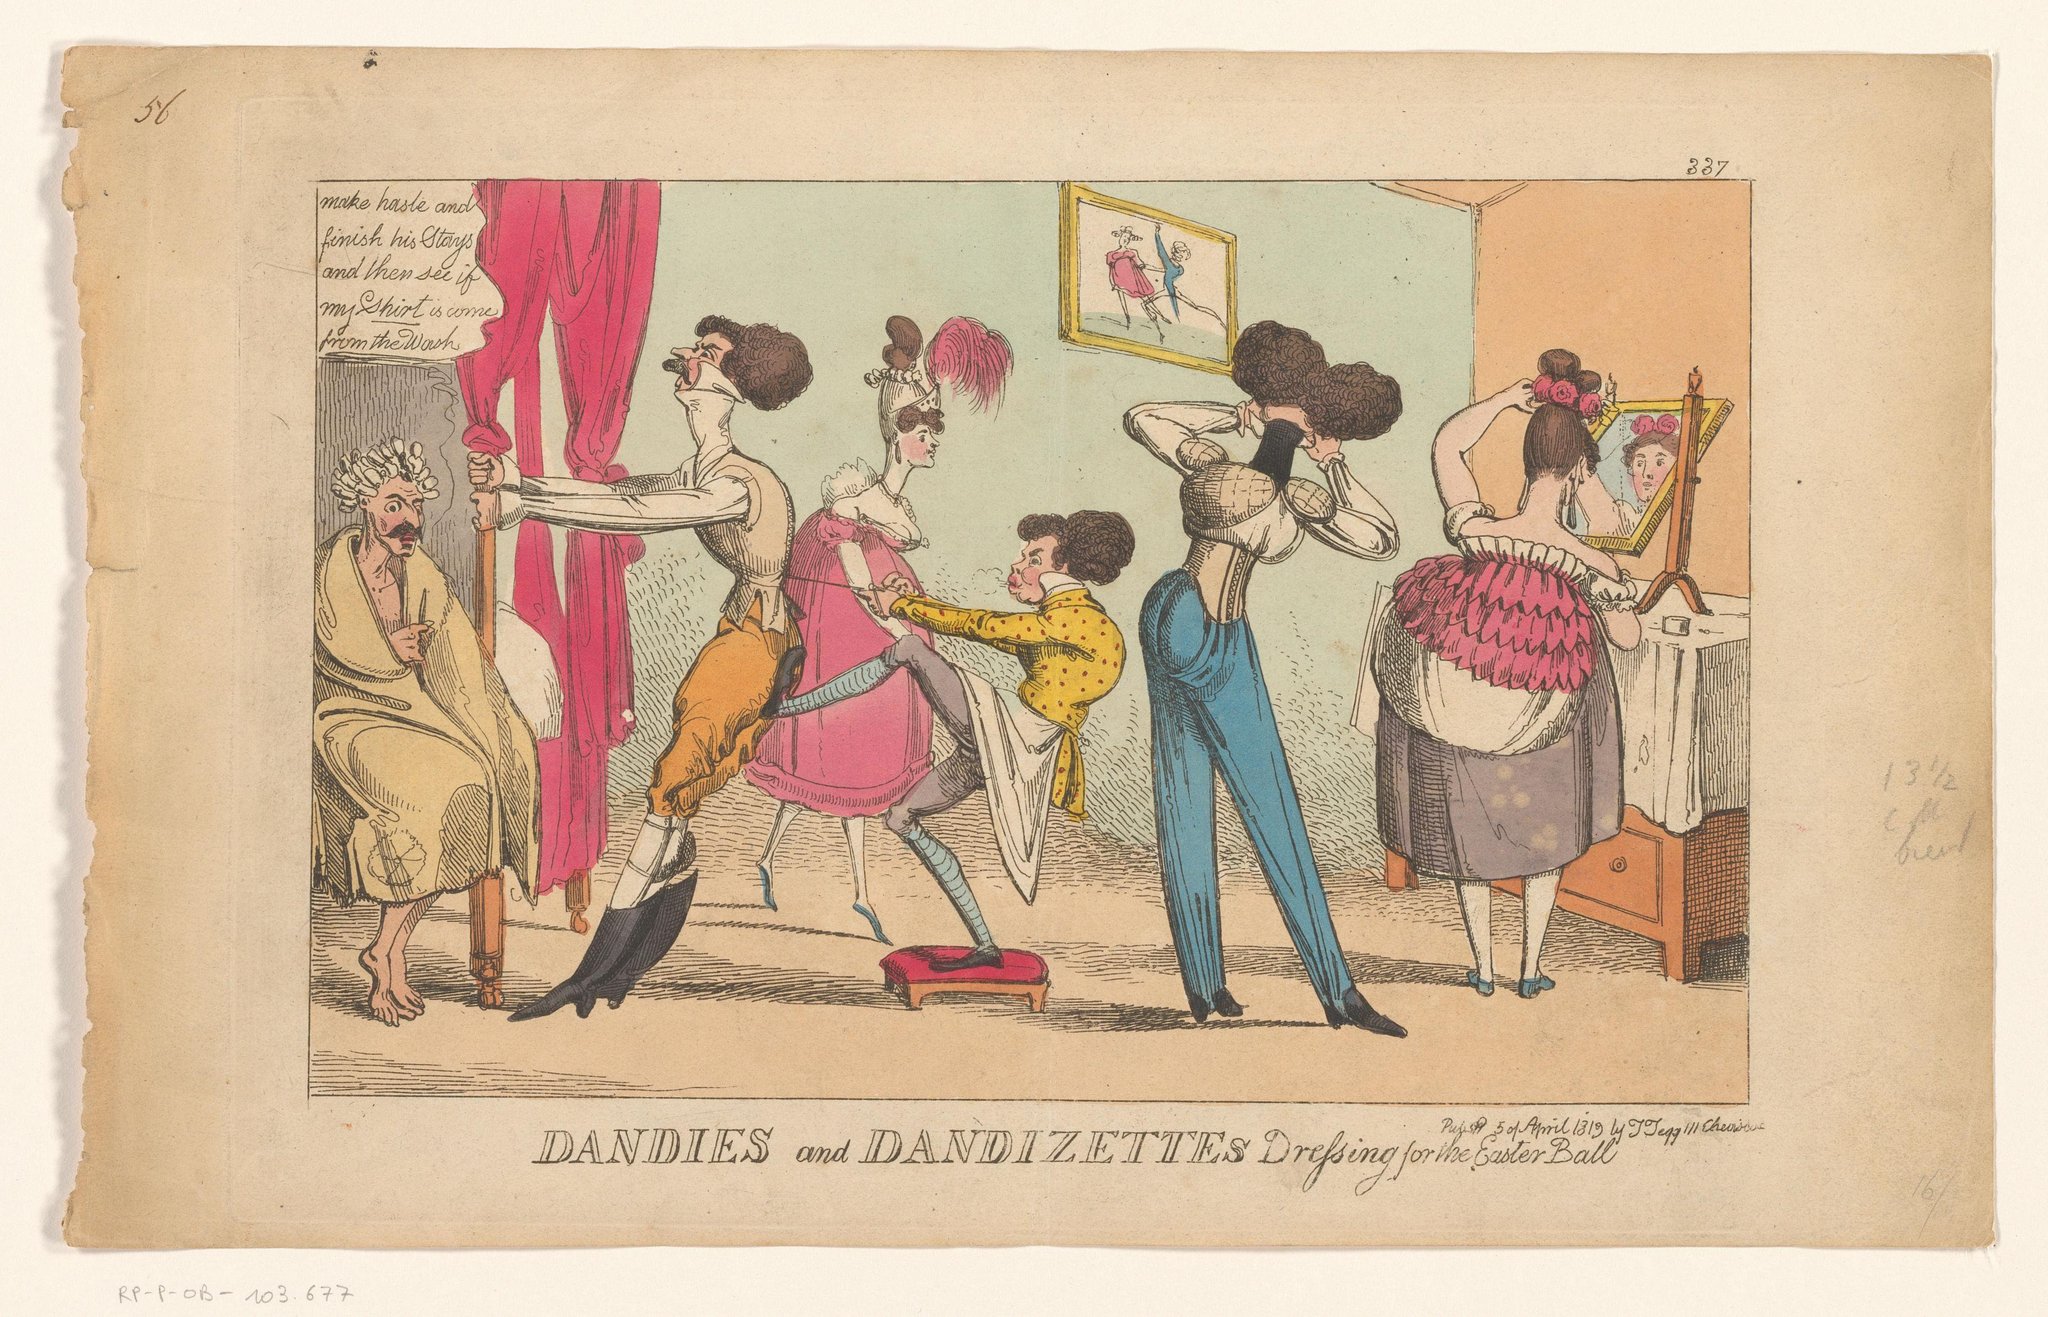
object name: fashion print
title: Dandies and Dandizettes dressing for the Easter Ball, 1819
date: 1819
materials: paper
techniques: etching, hand coloring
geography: london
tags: making toilet, dandy, beau, lacing up a corset, making toilet - aa - (for) women, dressing oneself, getting dressed - aa - female human figure, political caricatures and satires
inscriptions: address: ‘Publ. 5 of April 1819 by T. Tegg [...]’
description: Dandies en twee vrouwen maken toilet voor het bal. Bij een man wordt het corset strak aangeregen, de ander brengt hulpstukken aan. rechts een vrouw voor de spiegel, links zit een man in een badjas met krullers in het haar. Rechtsboven genummerd 337.